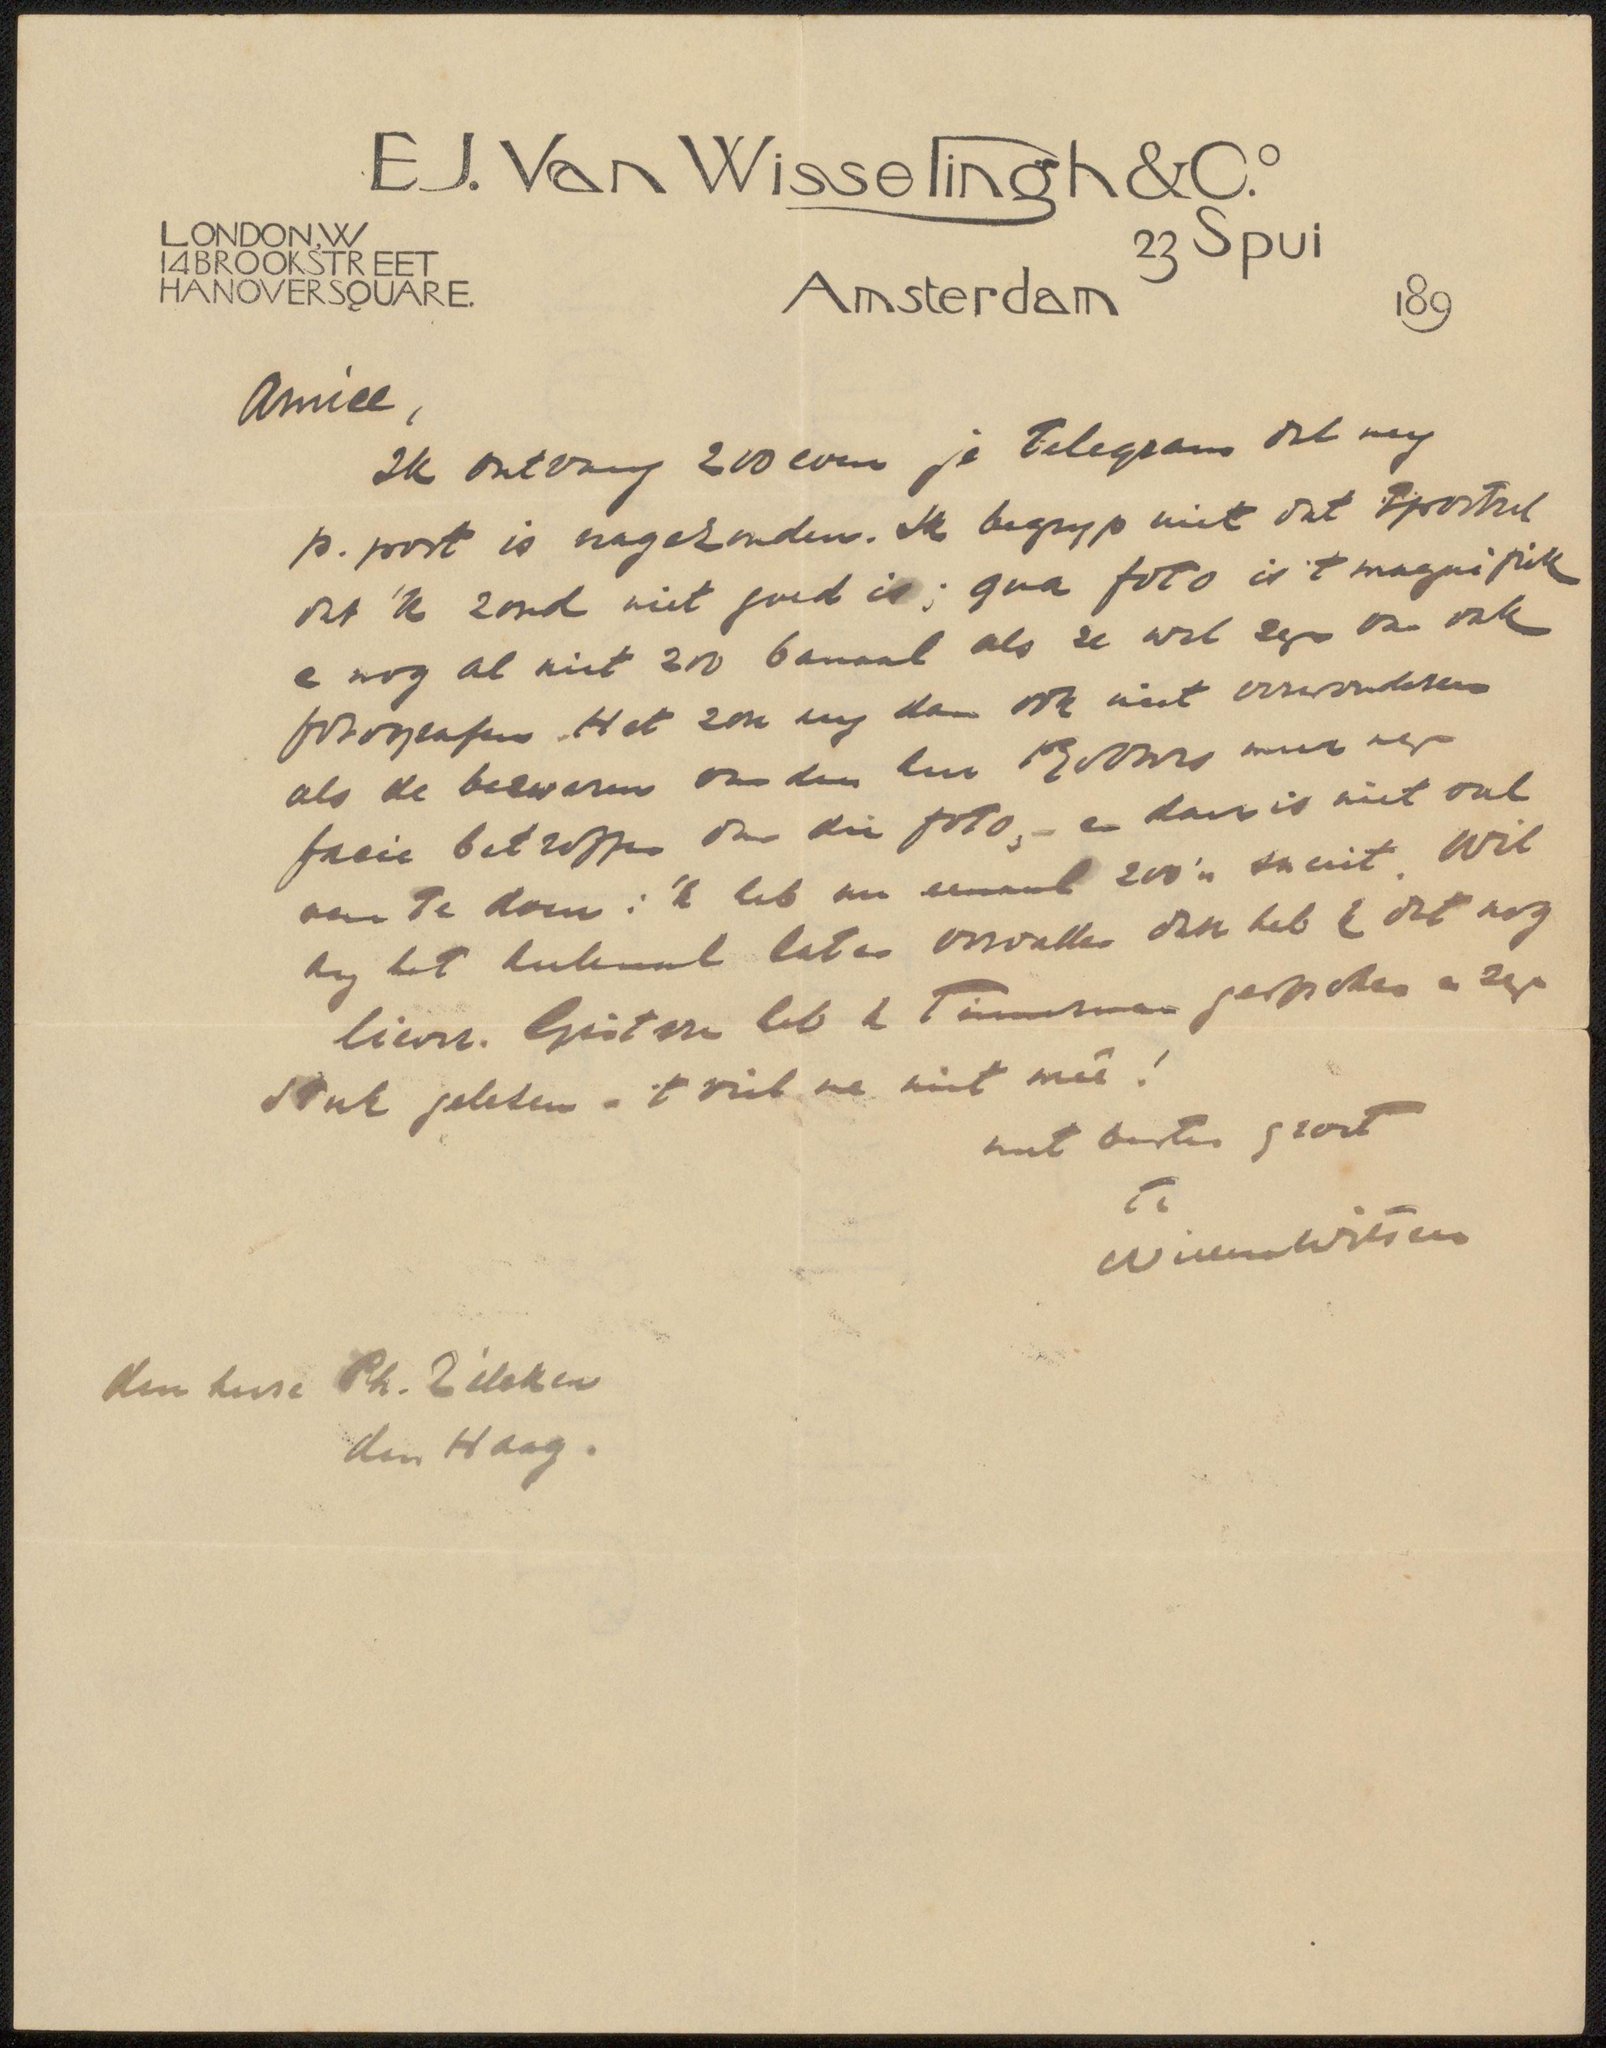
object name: letter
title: Brief aan Philip Zilcken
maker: willem witsen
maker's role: draughtsman, painter, print maker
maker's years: 1860-1923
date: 1890-1899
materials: ink, paper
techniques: pen, printing, writing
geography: amsterdam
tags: publisher, jacobus george robbers, aegidius willem timmerman, philip zilcken, photography, cinematography, historical persons (portraits and scenes from the life)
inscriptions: collector's mark: ‘RPK’, watermark